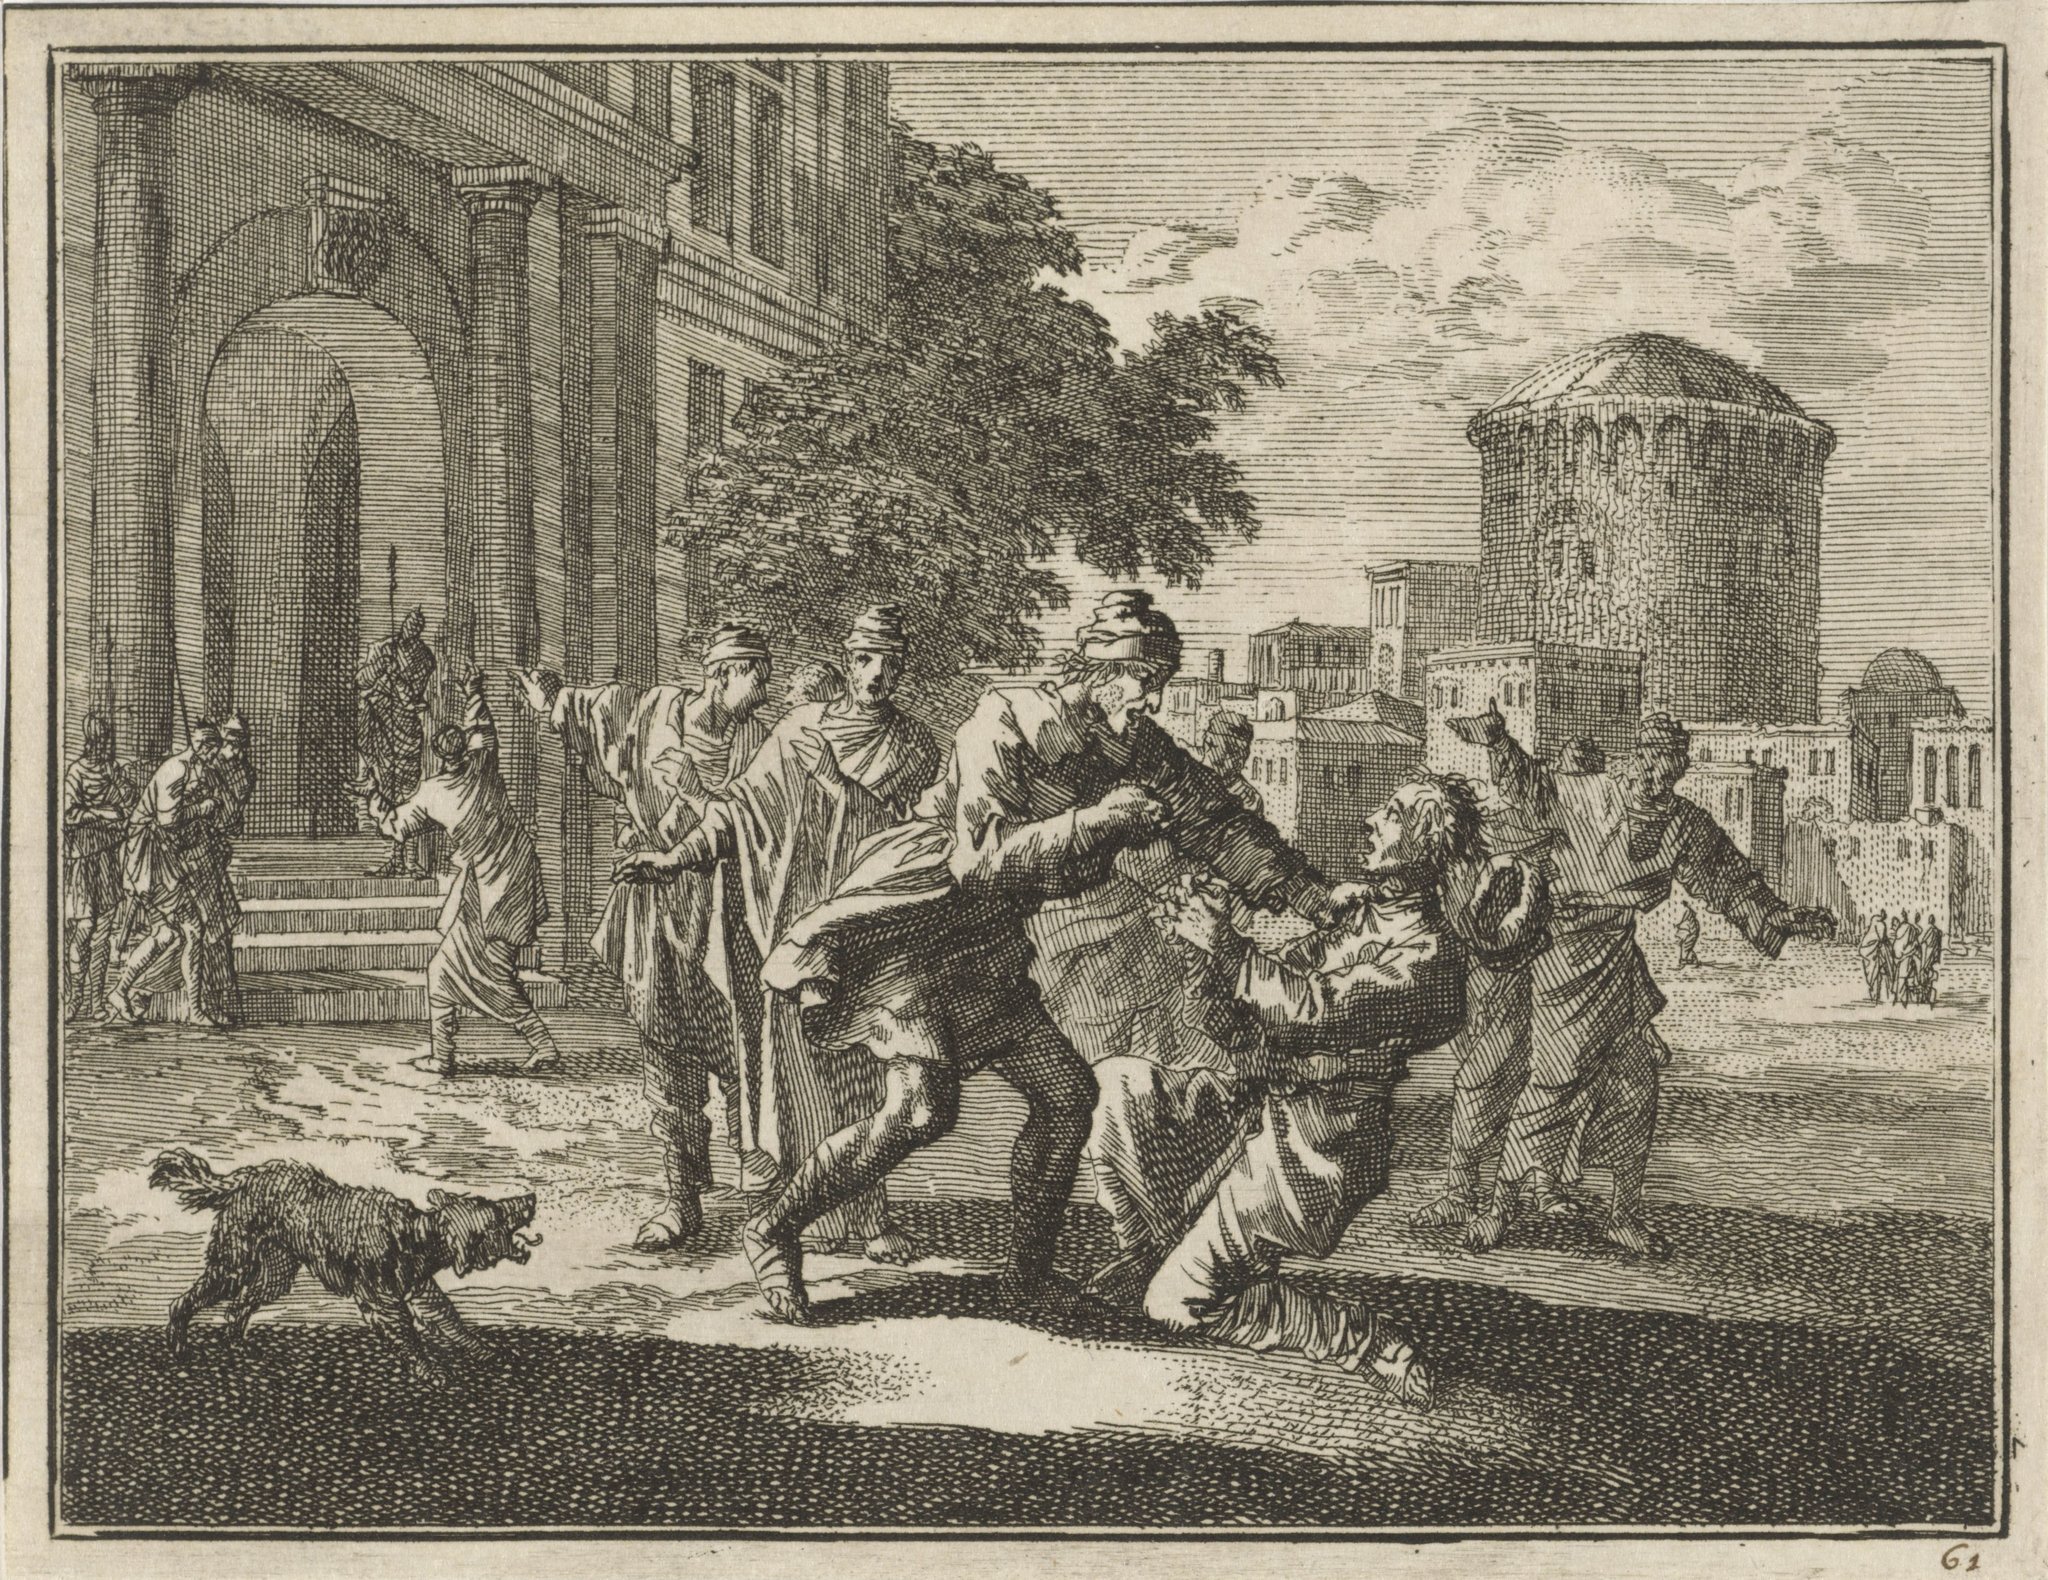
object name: print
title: Gelijkenis van de ondankbare dienstknecht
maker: jan luyken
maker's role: draughtsman, print maker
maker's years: 1649-1712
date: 1712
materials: paper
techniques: etching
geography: amsterdam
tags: the unmerciful servant: the king forgives him his debts ~ parable of christ (matthew 18:23-35)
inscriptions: number: ‘61’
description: Proefdruk van illustratie uit: Luyken, Jan. De schriftuurlyke geschiedenissen en gelykenissen van het Oude en Nieuwe Verbond, 2 delen. Amsterdam: Wed. Pieter Arentsz II en Cornelis van der Sys, 1712, dl. II.